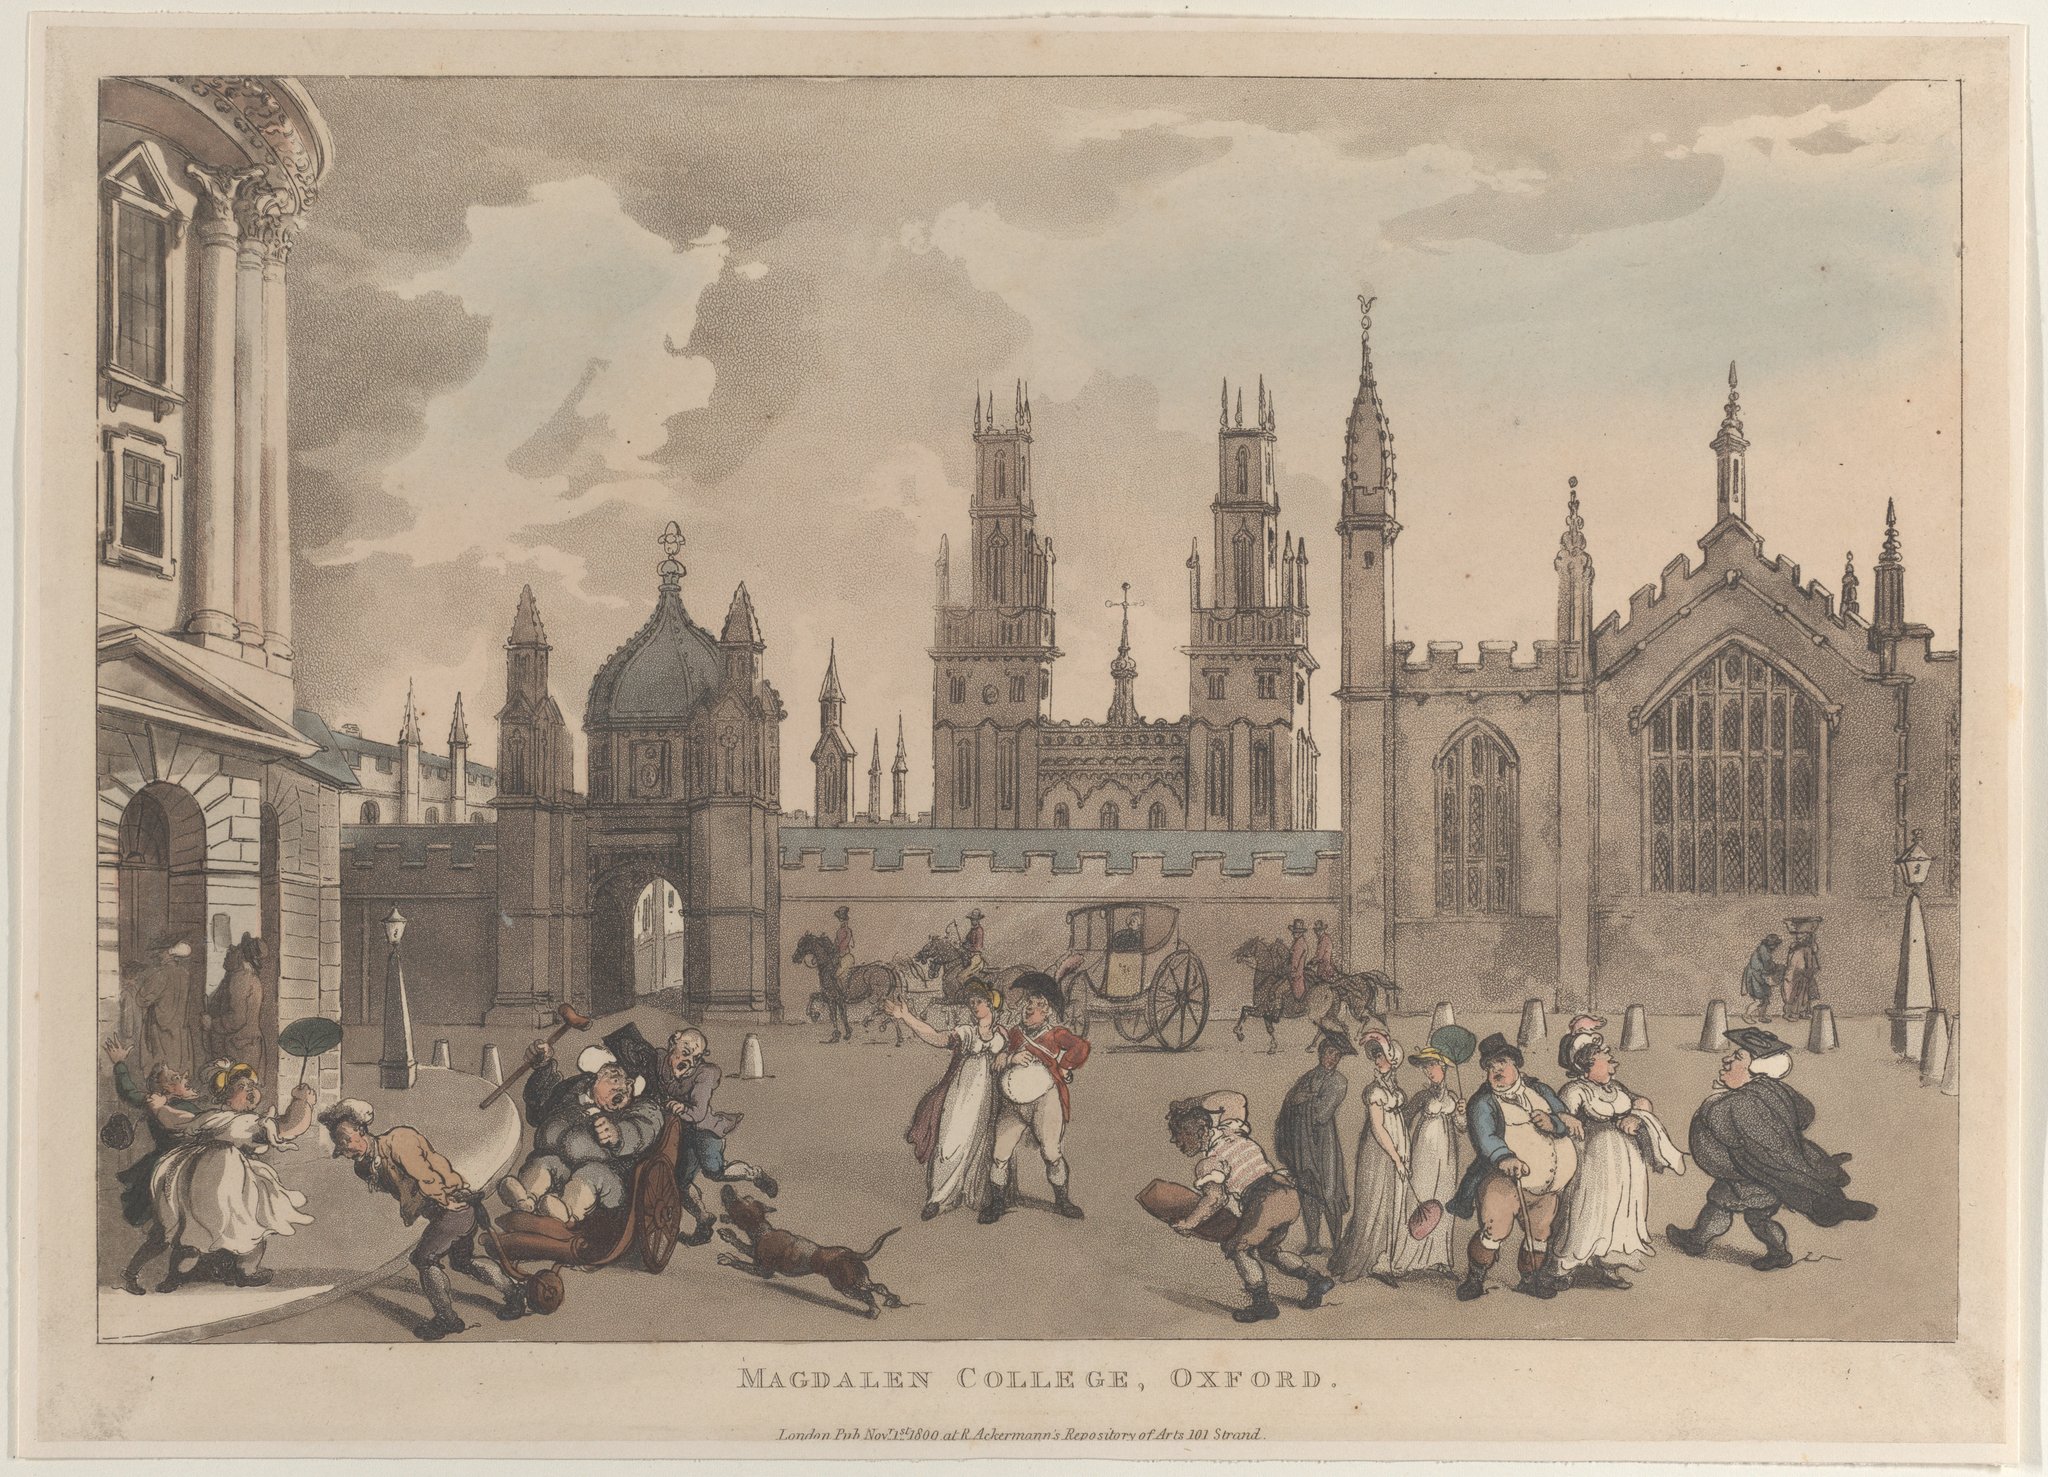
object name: print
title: Magdalen College, Oxford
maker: thomas rowlandson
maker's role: artist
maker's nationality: british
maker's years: 1757-1827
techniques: aquatint, etching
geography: london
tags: satire,schools,men,women,dogs